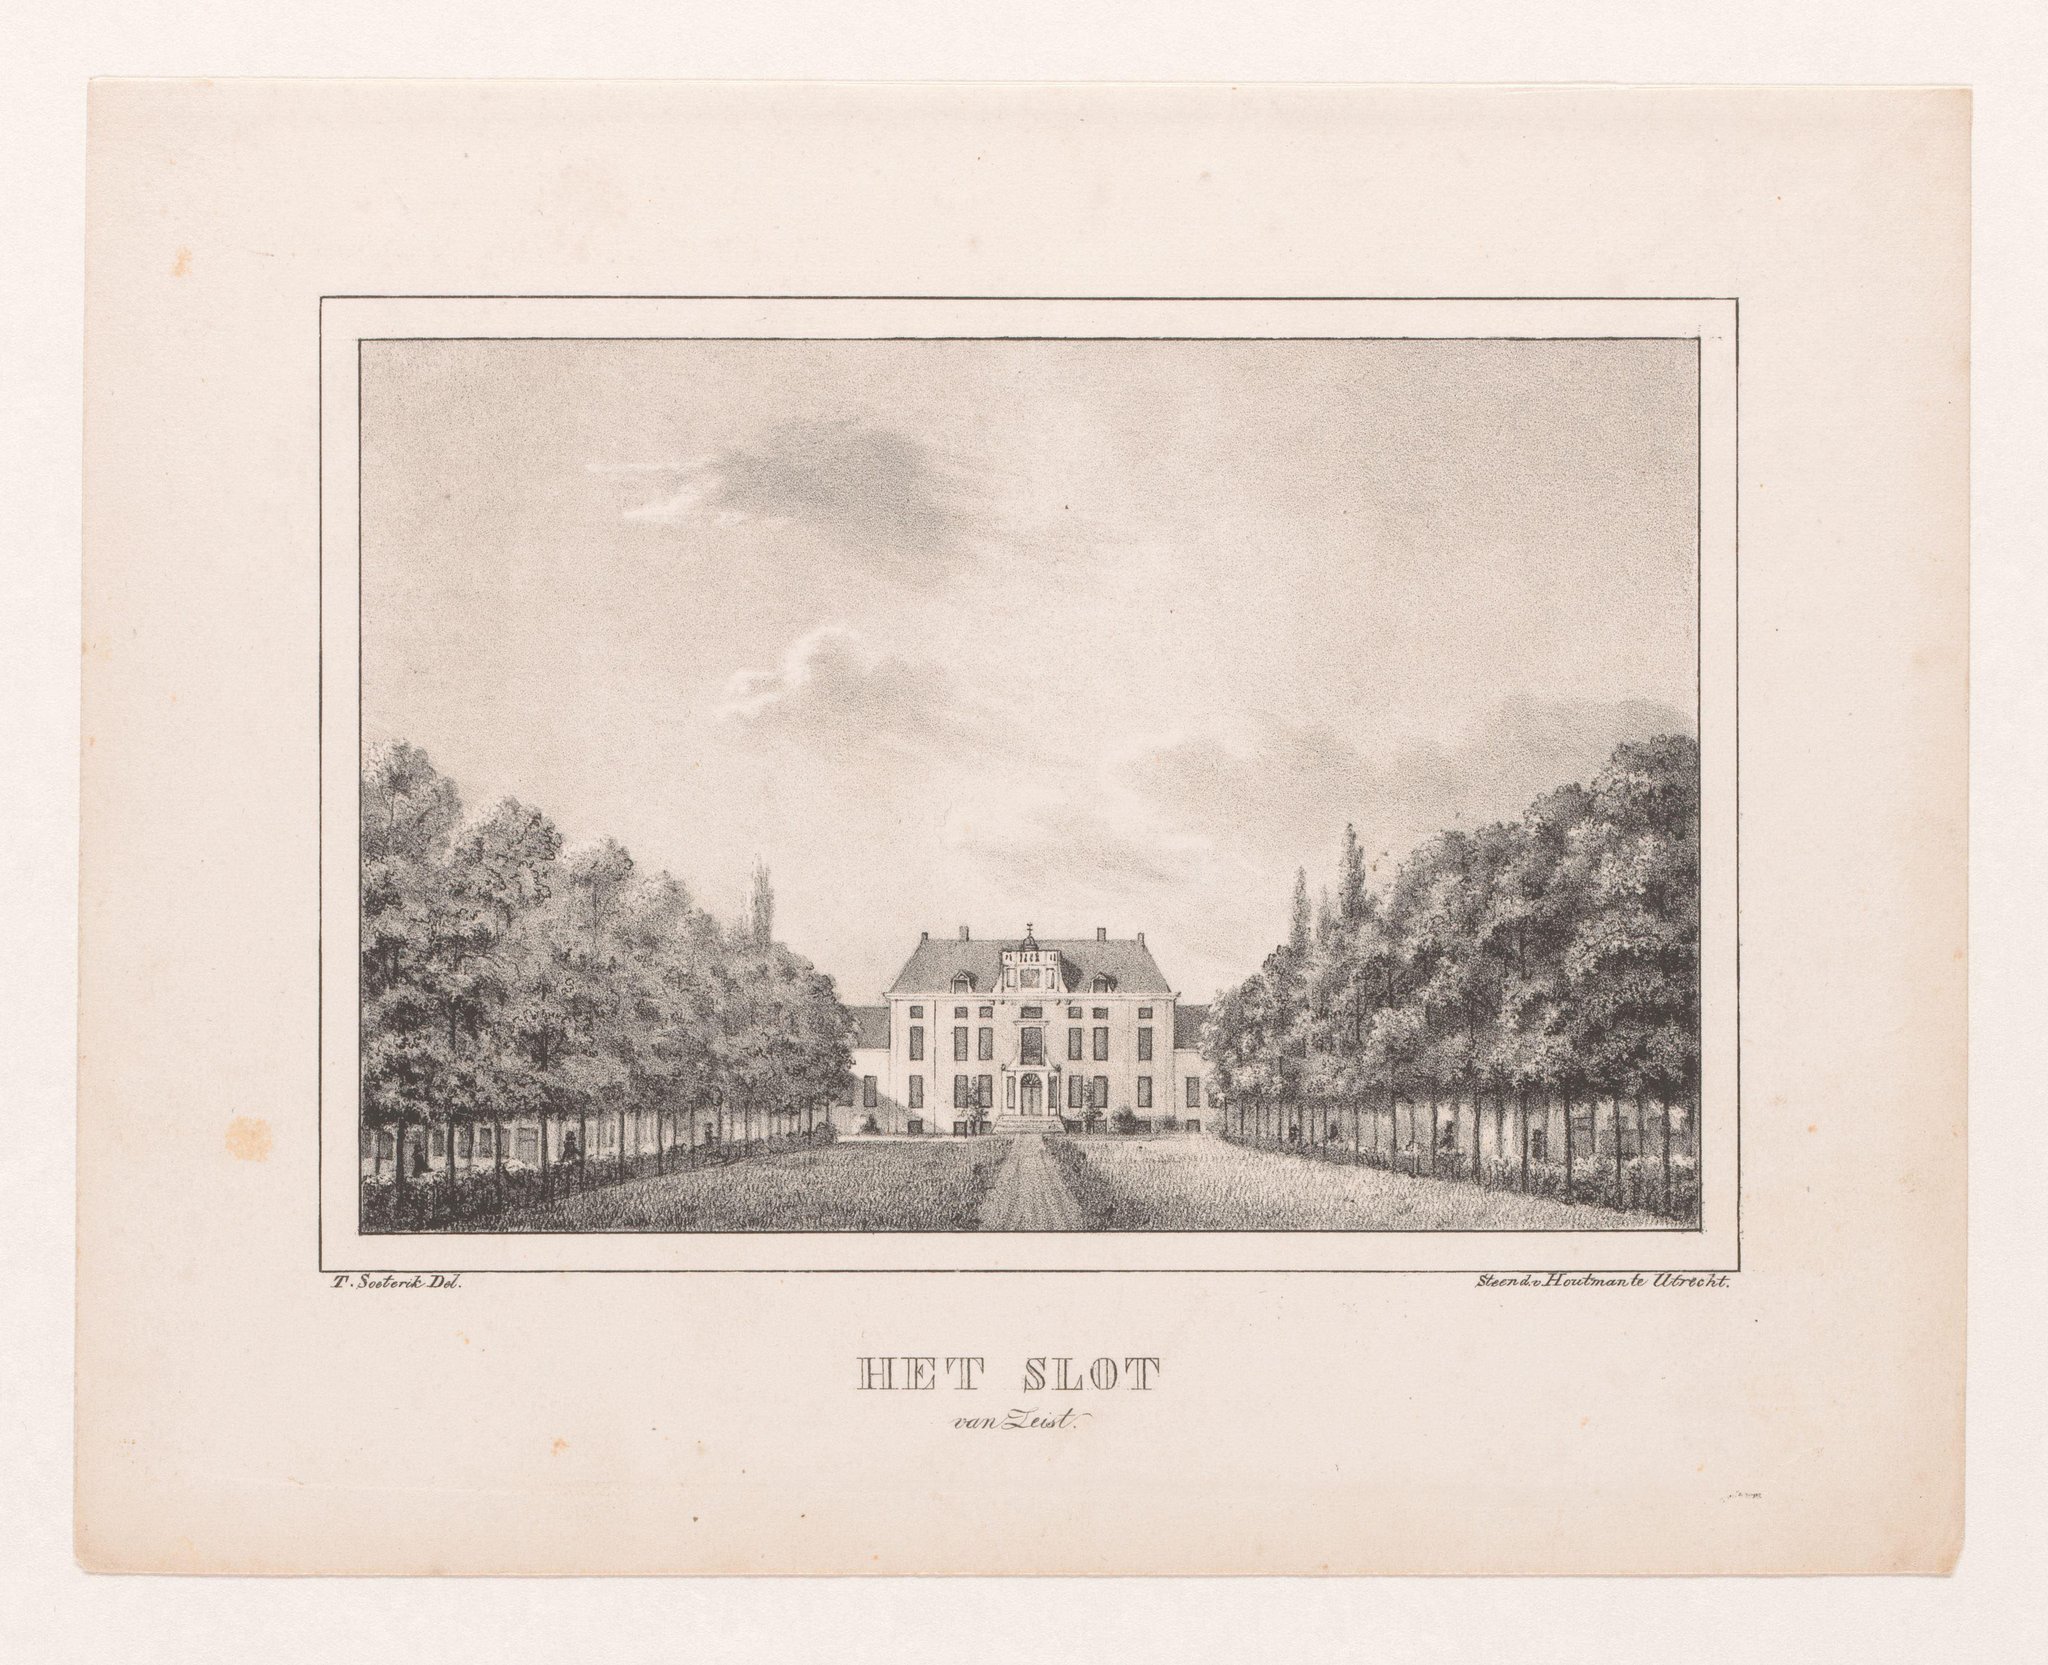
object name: book illustration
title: Slot Zeist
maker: johannes paulus houtman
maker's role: bookseller, print maker, printer, publisher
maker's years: 1803-1845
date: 1828-1830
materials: paper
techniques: lithograph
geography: utrecht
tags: castle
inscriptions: collector's mark: Lugt 2228, collector's mark: Lugt 2760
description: Prent uit: Mourot, M. Gezigten van buitenplaatsen en gebouwen gelegen tusschen de stad Utrecht en de Grebbe. Utrecht: Houtman, Johannes Paulus, 1828-1830.